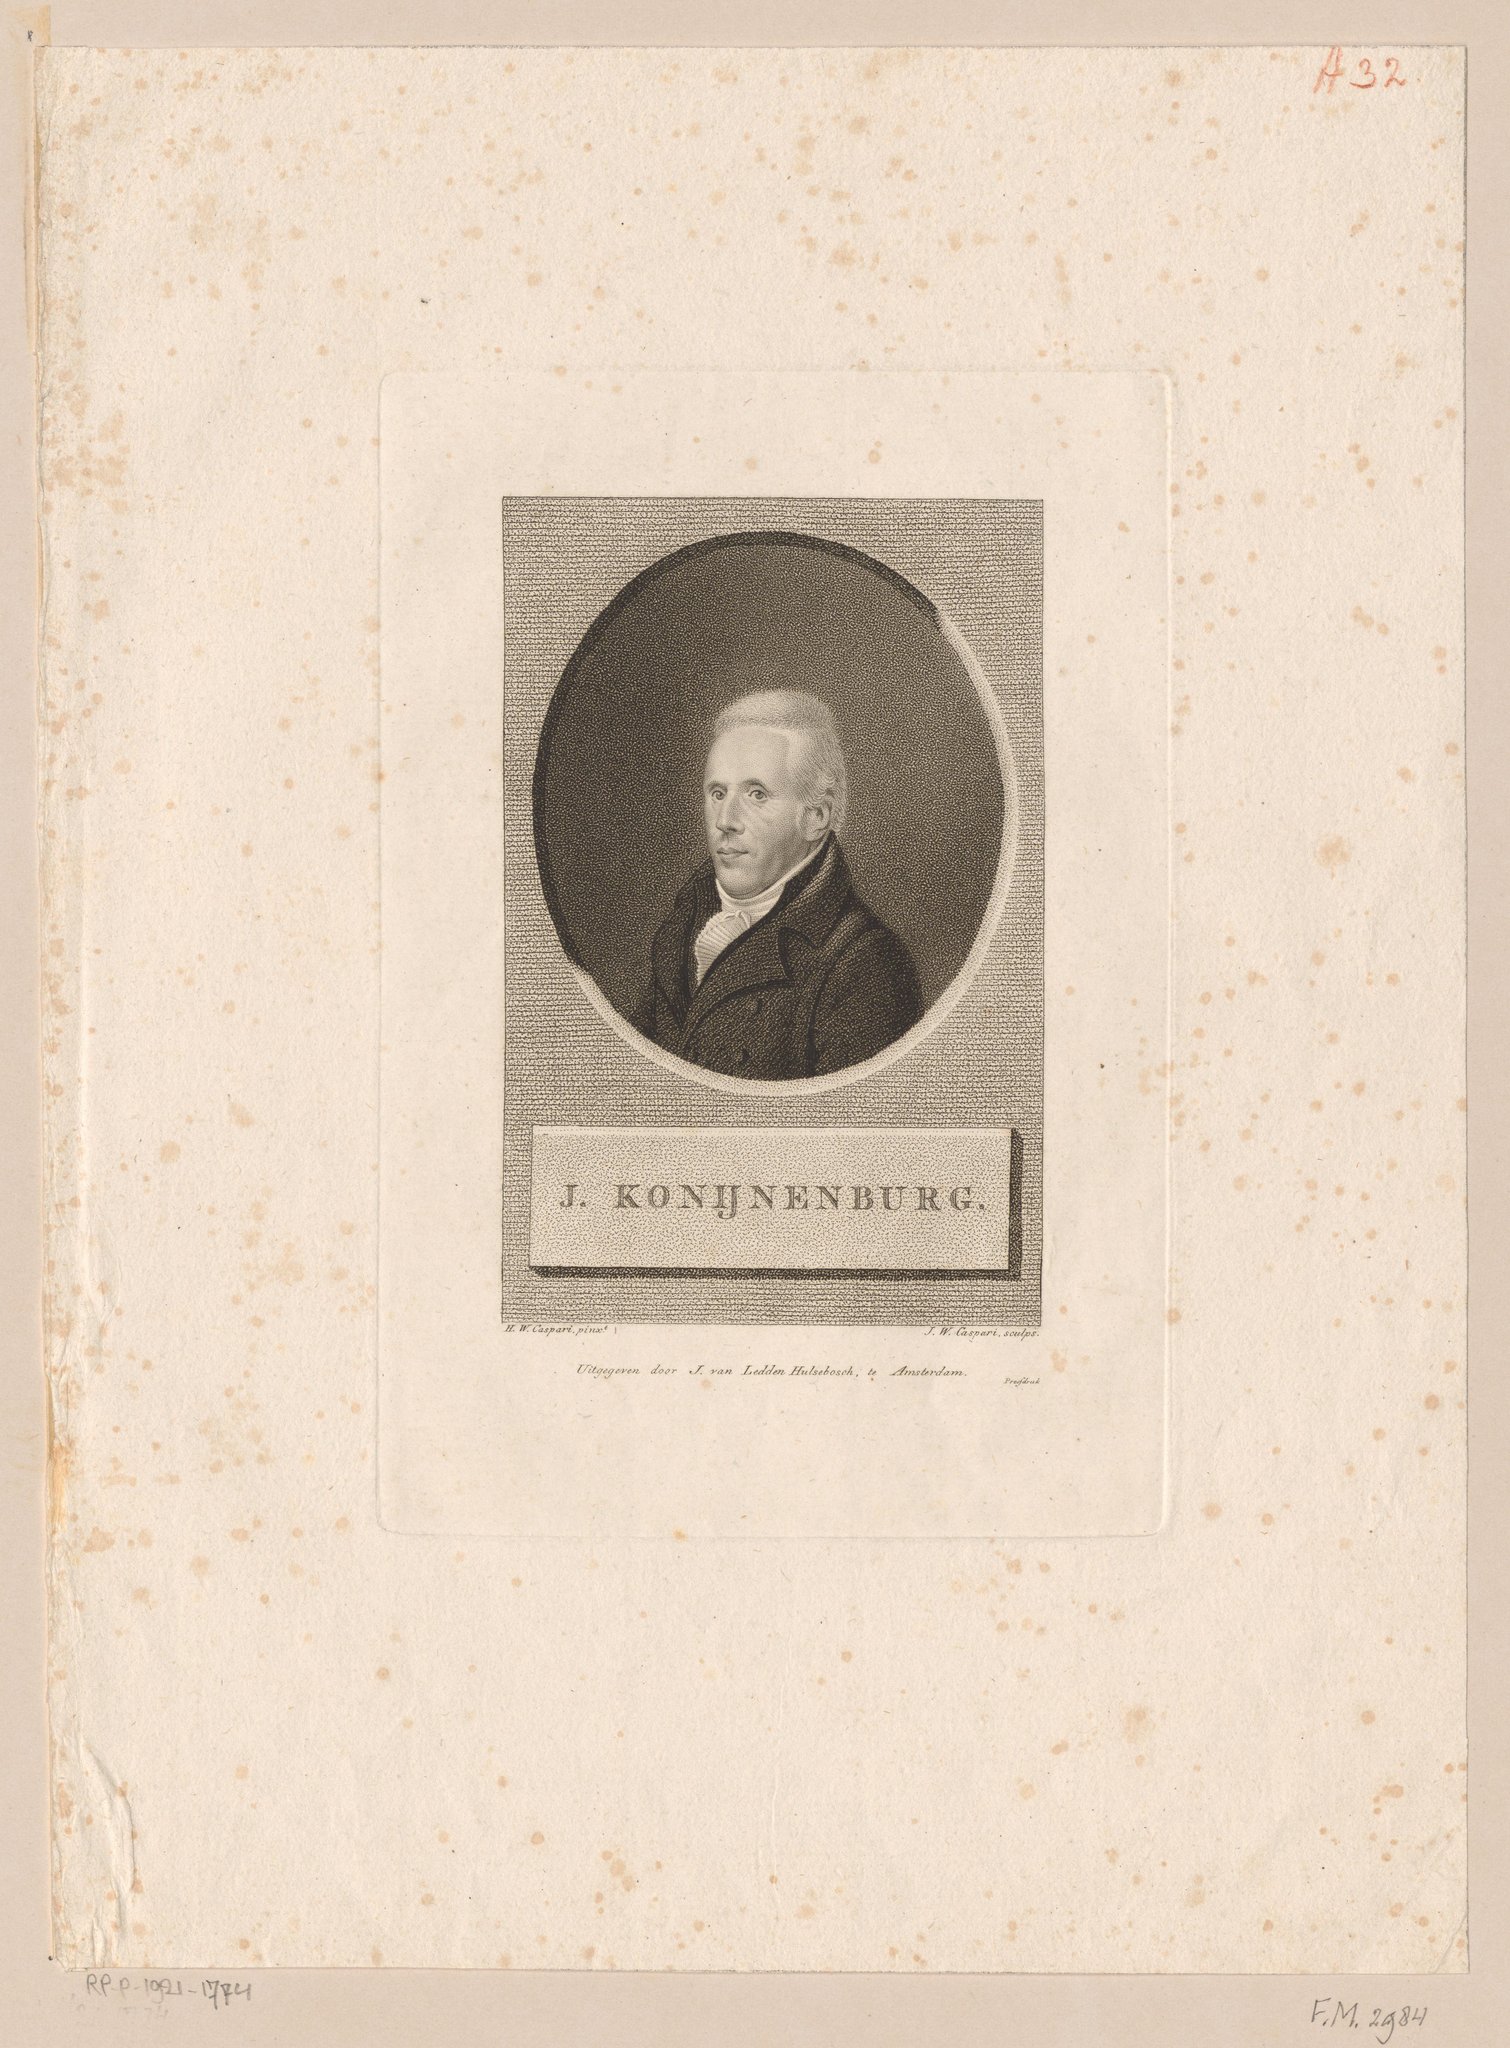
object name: print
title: Portret van Jan Konijnenburg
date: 1802-1819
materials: paper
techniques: etching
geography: amsterdam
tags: leiden, amsterdam, jan konijnenburg, historical persons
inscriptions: collector's mark: Lugt 2233